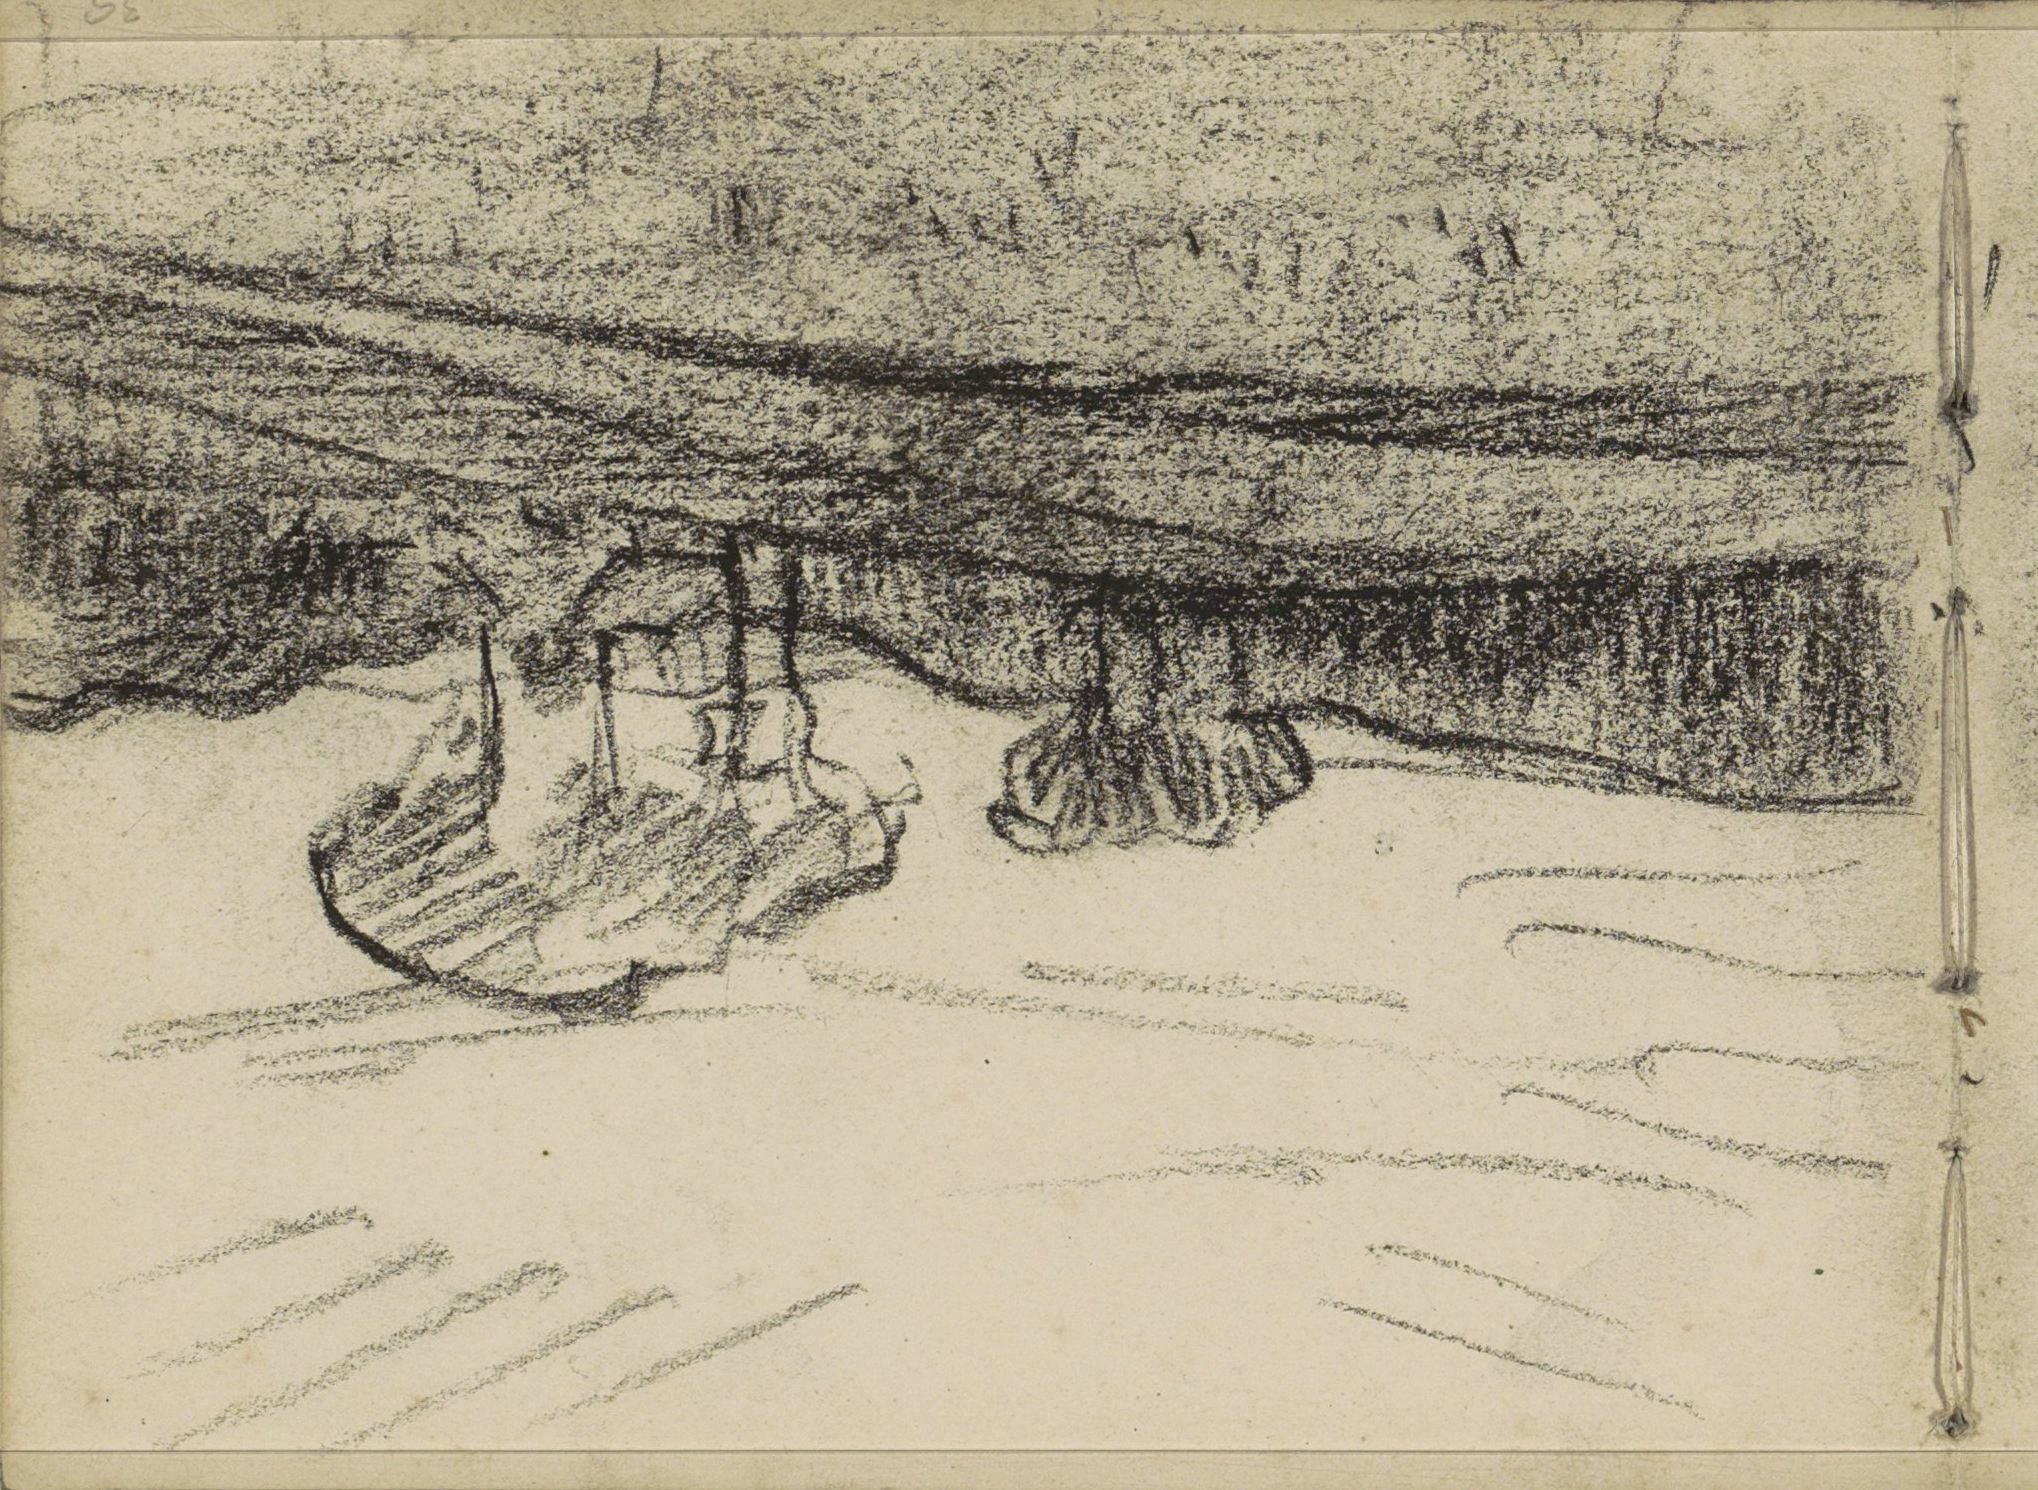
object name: sketchbook leaf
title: Heuvellandschap met bomen bij een huis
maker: hermannus adrianus van oosterzee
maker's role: draughtsman, painter, print maker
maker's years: 1863-1933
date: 1893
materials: charcoal, paper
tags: low hill country, farm or solitary house in landscape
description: Blad 8 verso uit een schetsboek met 23 bladen.